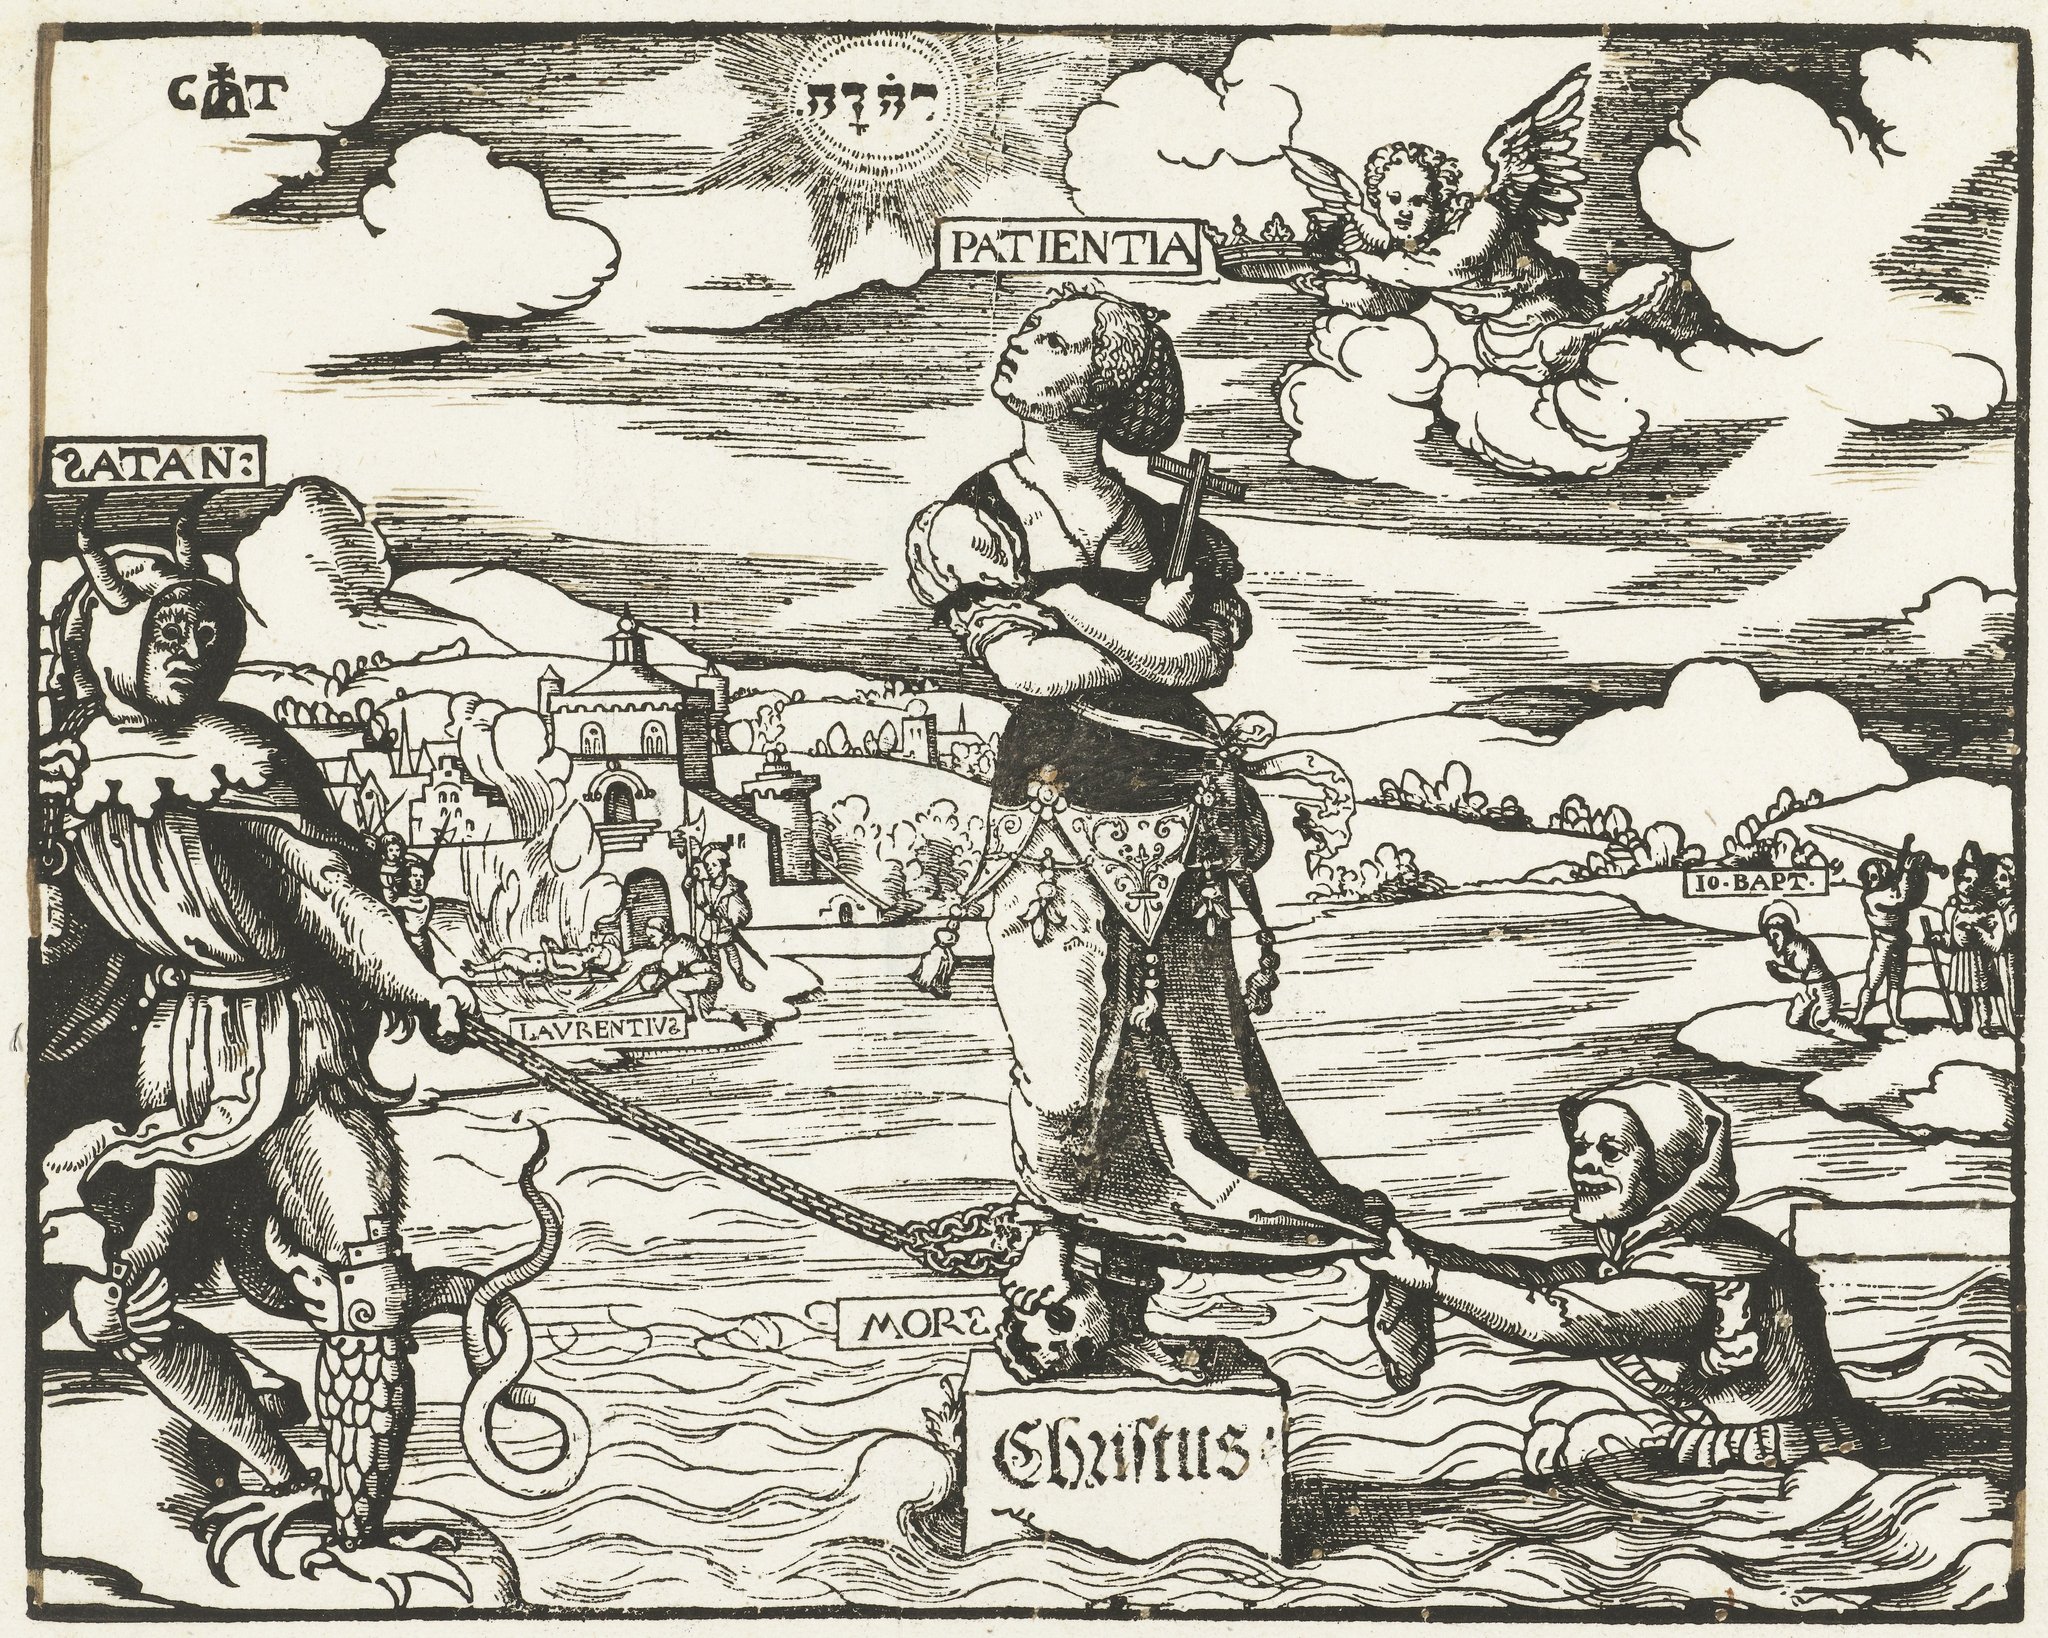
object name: print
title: Geduld (Patientia) op een steen in het water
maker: cornelis anthonisz.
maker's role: draughtsman, painter, print maker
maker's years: 1499-1553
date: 1507-1553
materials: paper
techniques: pen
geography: low countries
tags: st. laurence is roasted on a gridiron, patience; 'patienza' (ripa), devil(s) and demons: satan, the beheading of john the baptist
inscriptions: collector's mark: Lugt 240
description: Geduld (Patientia) op een steen in het water, voet leunt op schedel, kruis in haar hand. Op steen staat het woord Christus. Haar been zit aan ketting die Satan aan haar rechterkant vast heeft. Aan andere kant trekt een figuur aan haar mantel. Engel komt aanvliegen met kroon. In landschap op achtergrond de onthoofding van Johannes de Doper en het martelaarschap van de heilige Laurentius.